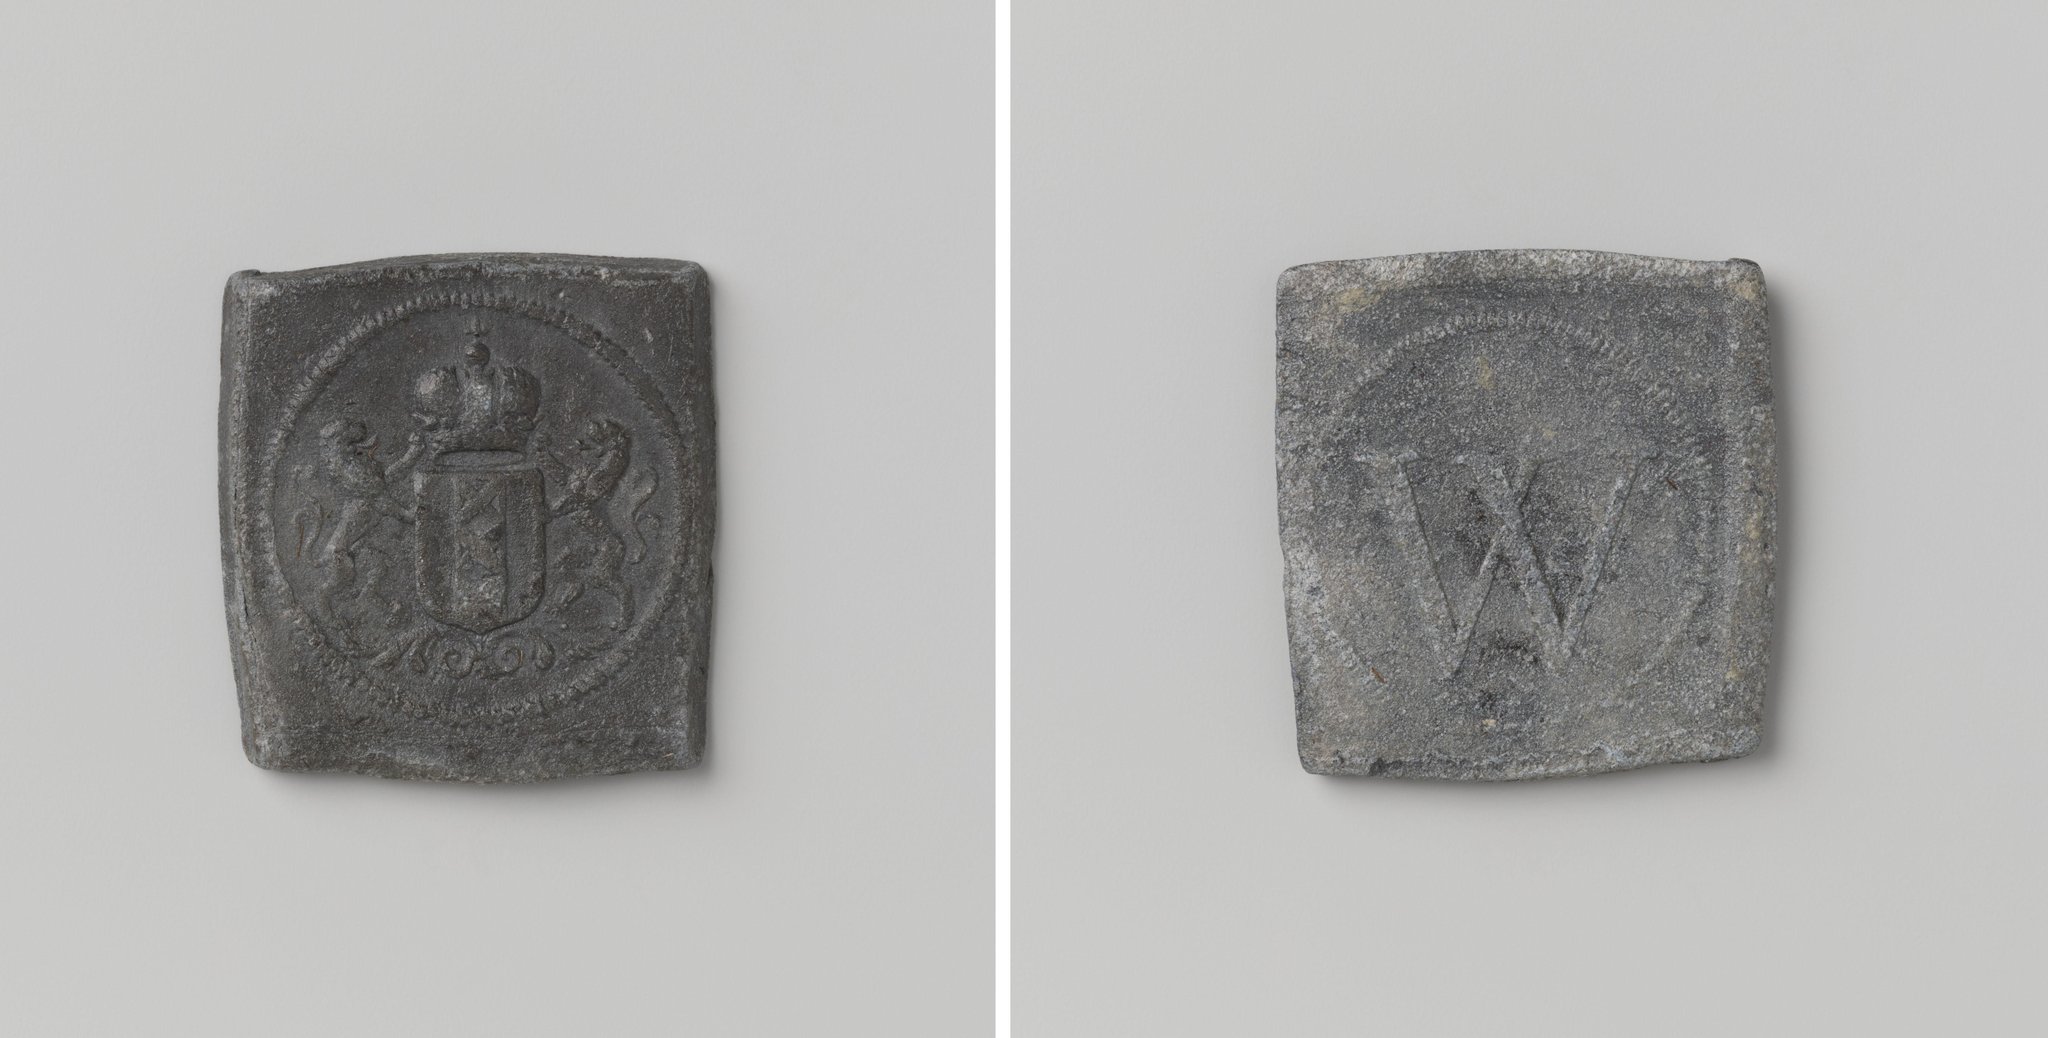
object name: alms token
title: Stad Amsterdam, penning die recht gaf op roggebrood tegen een prijs van achteneenhalve stuiver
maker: Anonymous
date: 1662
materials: lead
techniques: casting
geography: amsterdam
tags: amsterdam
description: bijna ruitvormige penning. Voorzijde: in ronde stempel: gekroond wapenschild, geflankeerd door twee leeuwen binnen ronde parelrand. Keerzijde: in ronde stempel: letter W binnen ronde parelrand